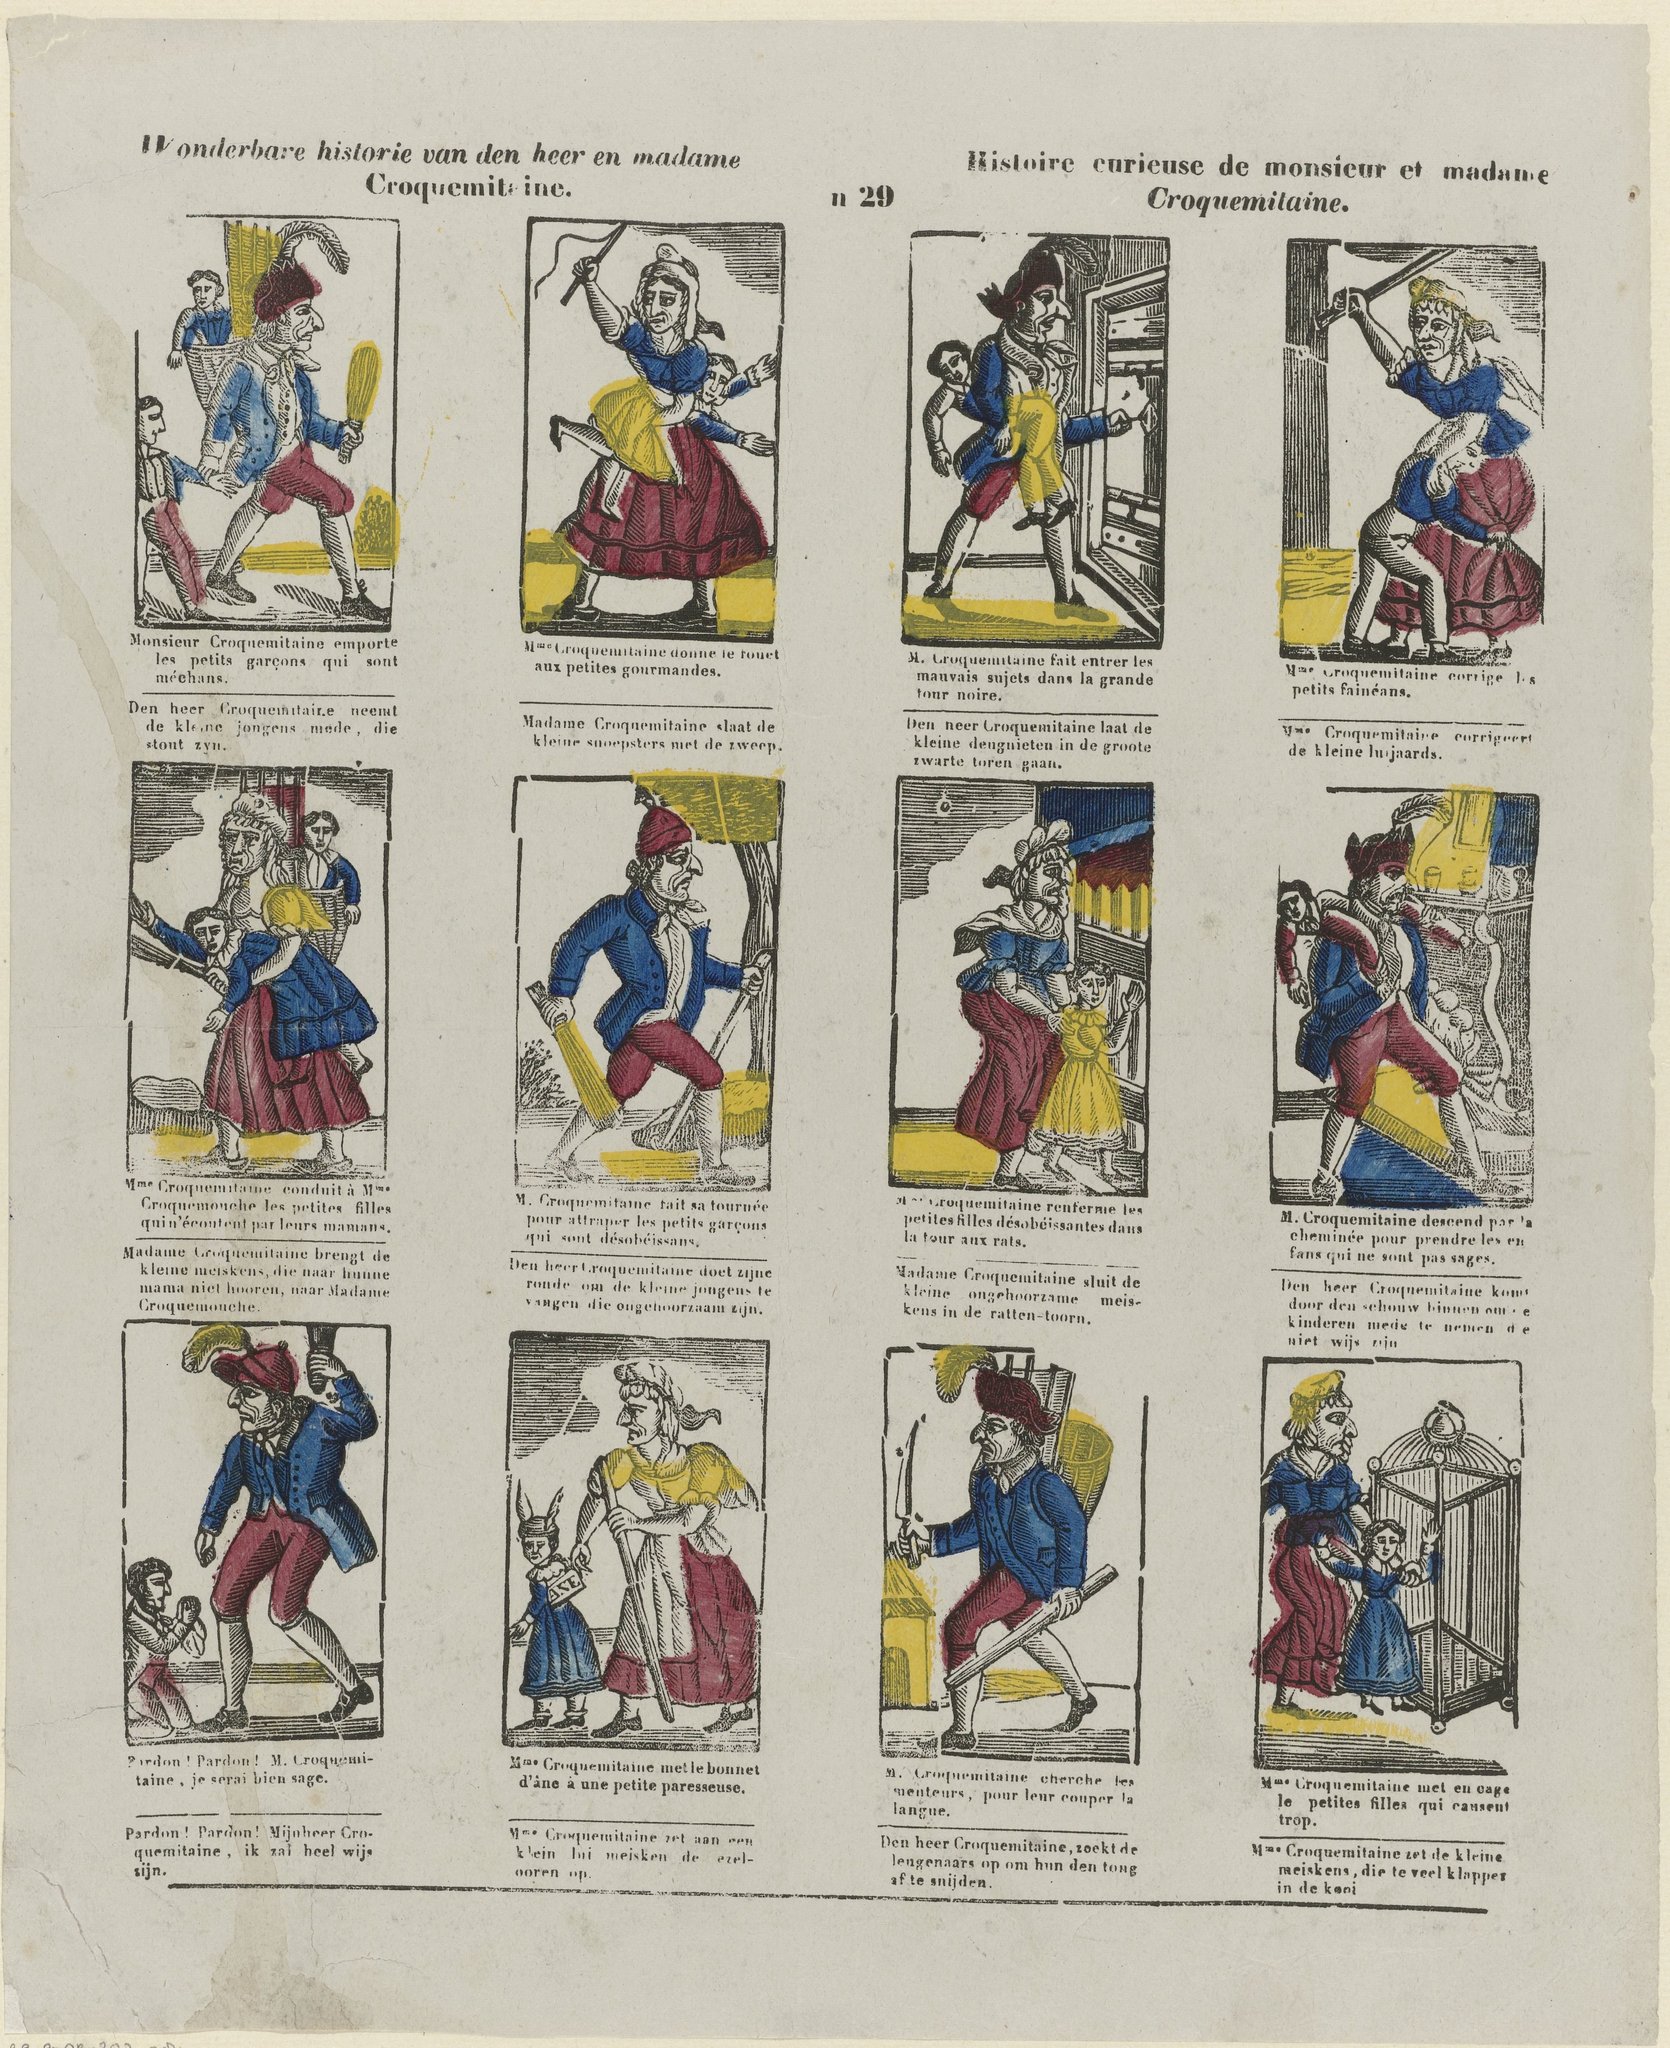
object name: popular print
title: Wonderbare historie van den heer en madame / Croquemitaine / Histoire curieuse de monsieur et madame / Croquemitaine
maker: Anonymous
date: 1856-1900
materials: paper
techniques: colour, letterpress printing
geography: turnhout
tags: correction of naughty children, bad behaviour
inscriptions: collector's mark: Lugt 2760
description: Blad met 12 voorstellingen over het leven van meneer en mevrouw Croquemitaine die stoute kinderen straffen. Onder elke afbeelding een tweeregelig vers in het Nederlands en in het Frans. Genummerd midden boven: n 29.